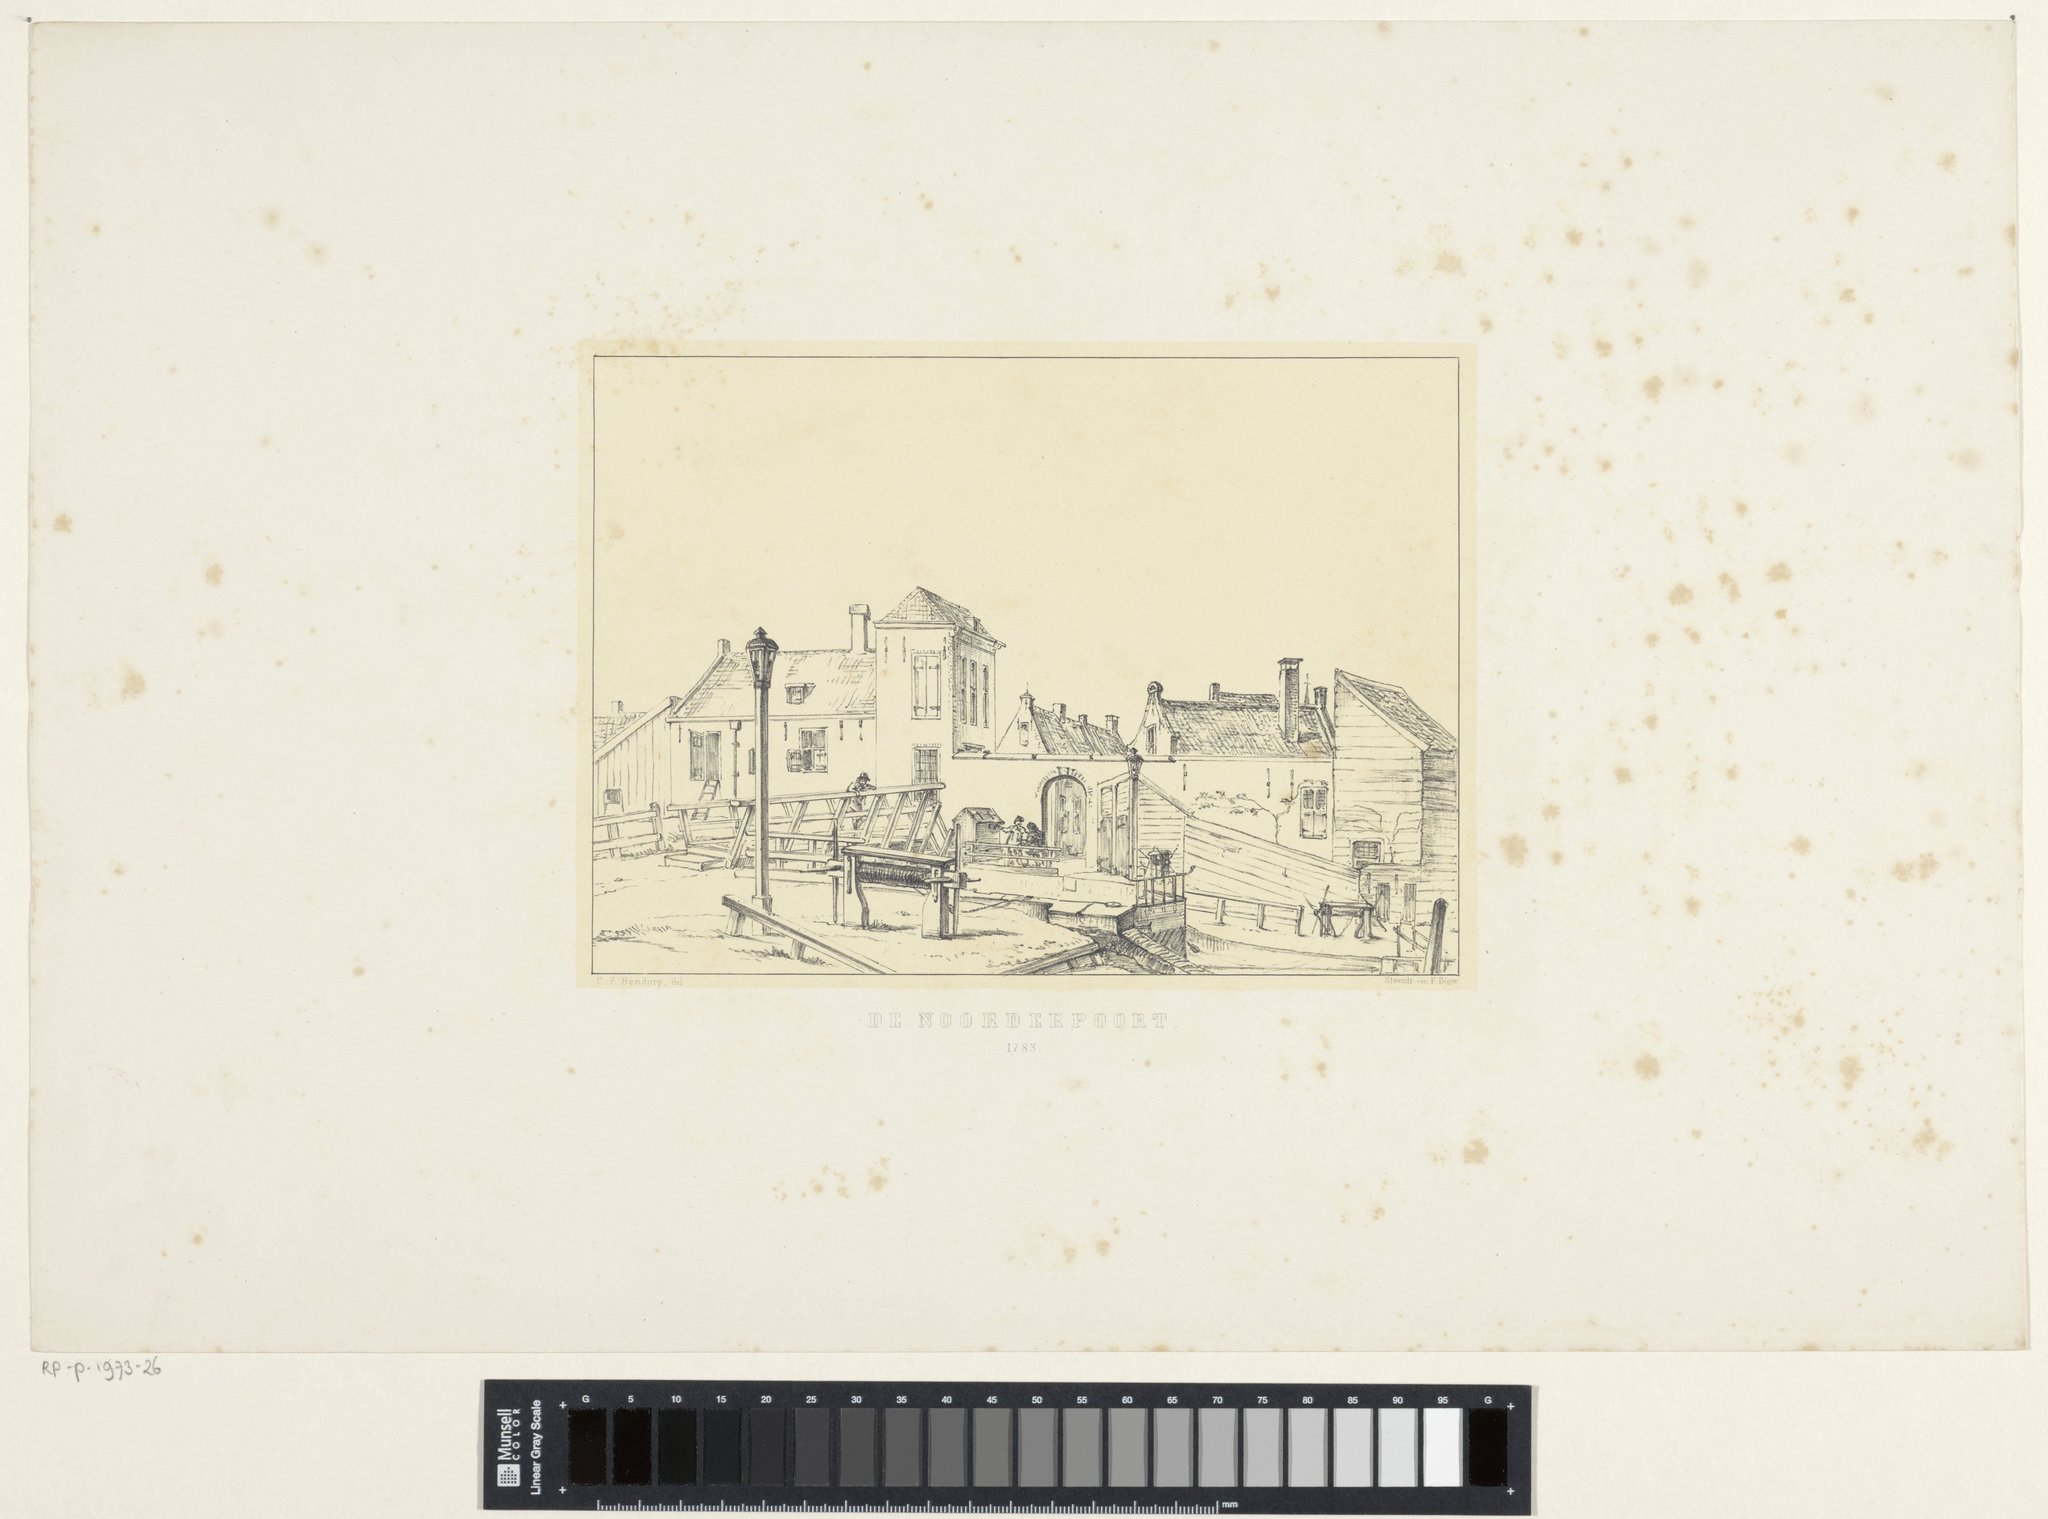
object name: print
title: De Noorderpoort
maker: carel frederik bendorp (ii)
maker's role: draughtsman, painter, print maker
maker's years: 1819-1897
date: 1872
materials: paper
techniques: tone lithography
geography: dordrecht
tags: sluice, weir, street lighting, bridge, city-gate, dordrecht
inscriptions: collector's mark: Lugt 2760, collector's mark: Lugt 2228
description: Een houten brug loopt over een sluis. Op de brug staat een figuur, hij kijkt naar beneden. In de voorgrond staat een lantaarnpaal. Onder de afbeelding het jaartal 1783.